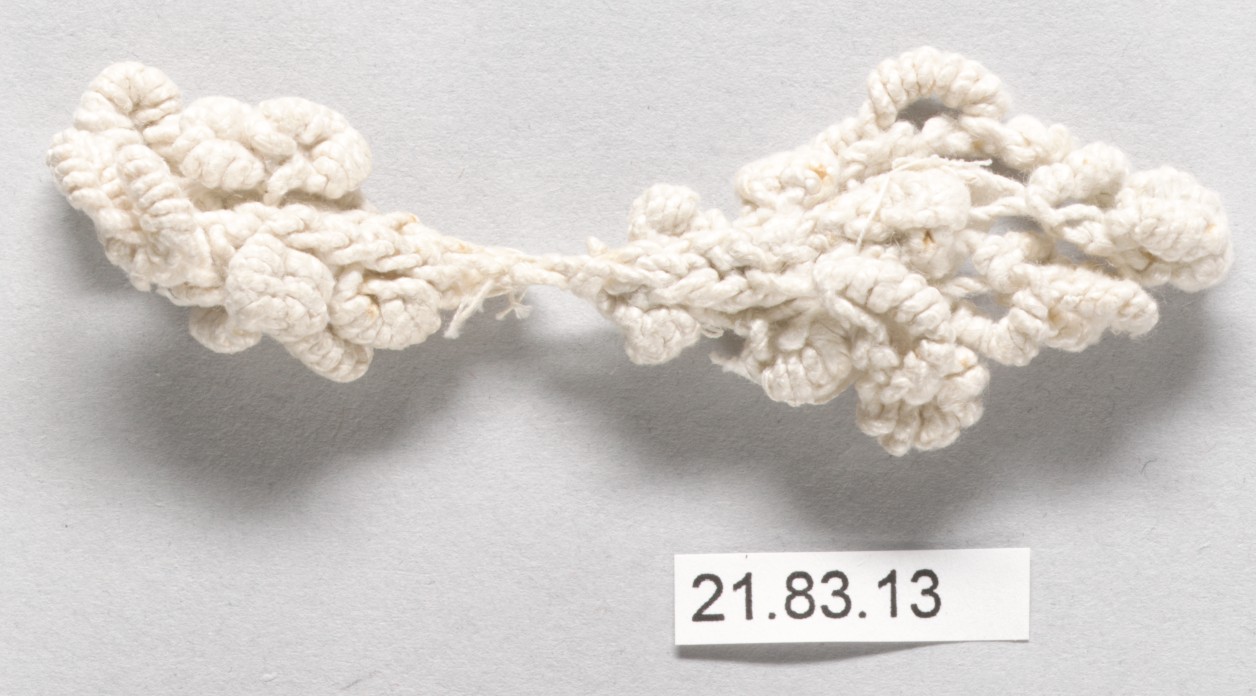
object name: tassel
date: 1601-1700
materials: linen